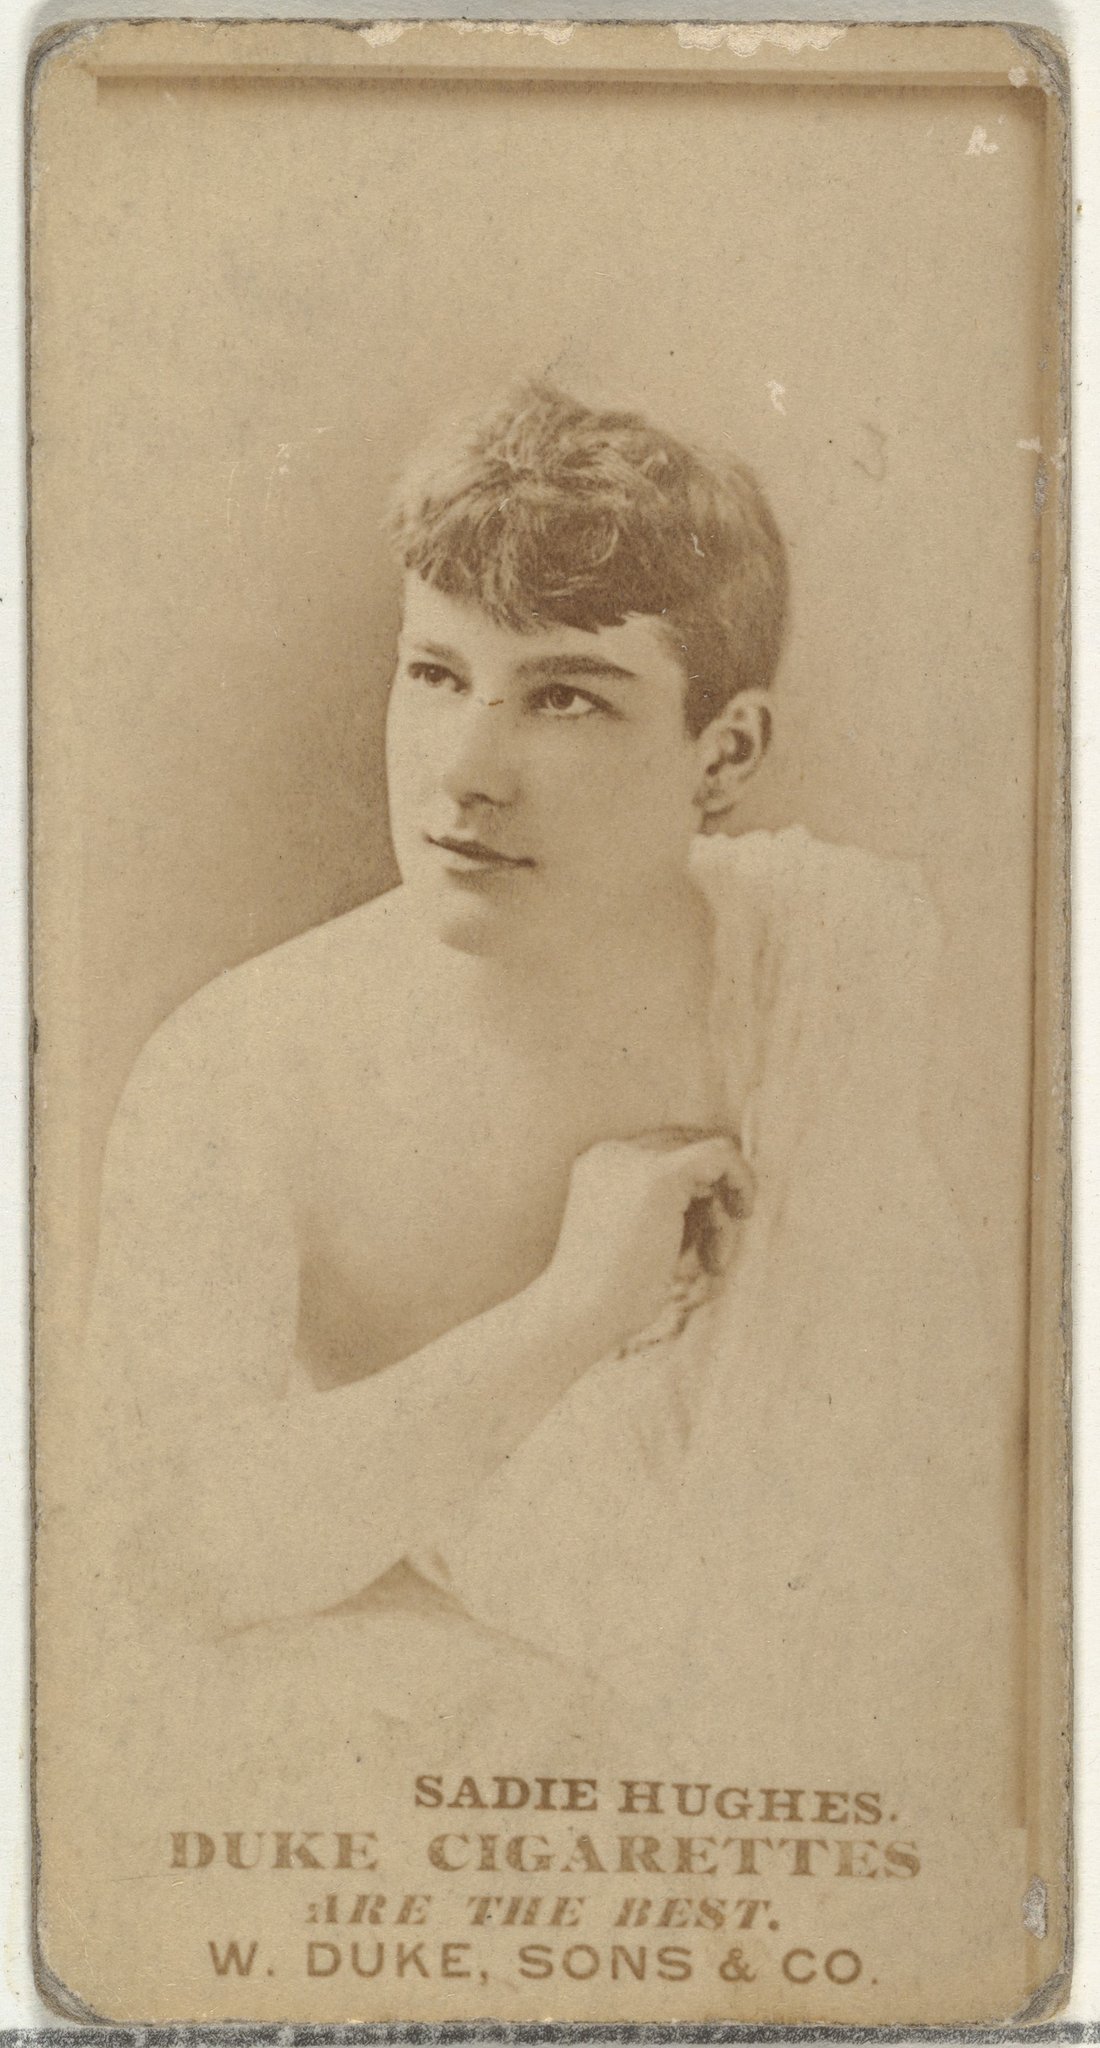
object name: photograph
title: Sadie Hughes, from the Actors and Actresses series (N145-7) issued by Duke Sons & Co. to promote Duke Cigarettes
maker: w. duke, sons & co.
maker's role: publisher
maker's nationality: american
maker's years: 1870-1920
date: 1880-1889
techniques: albumen silver print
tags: men,portraits,actors